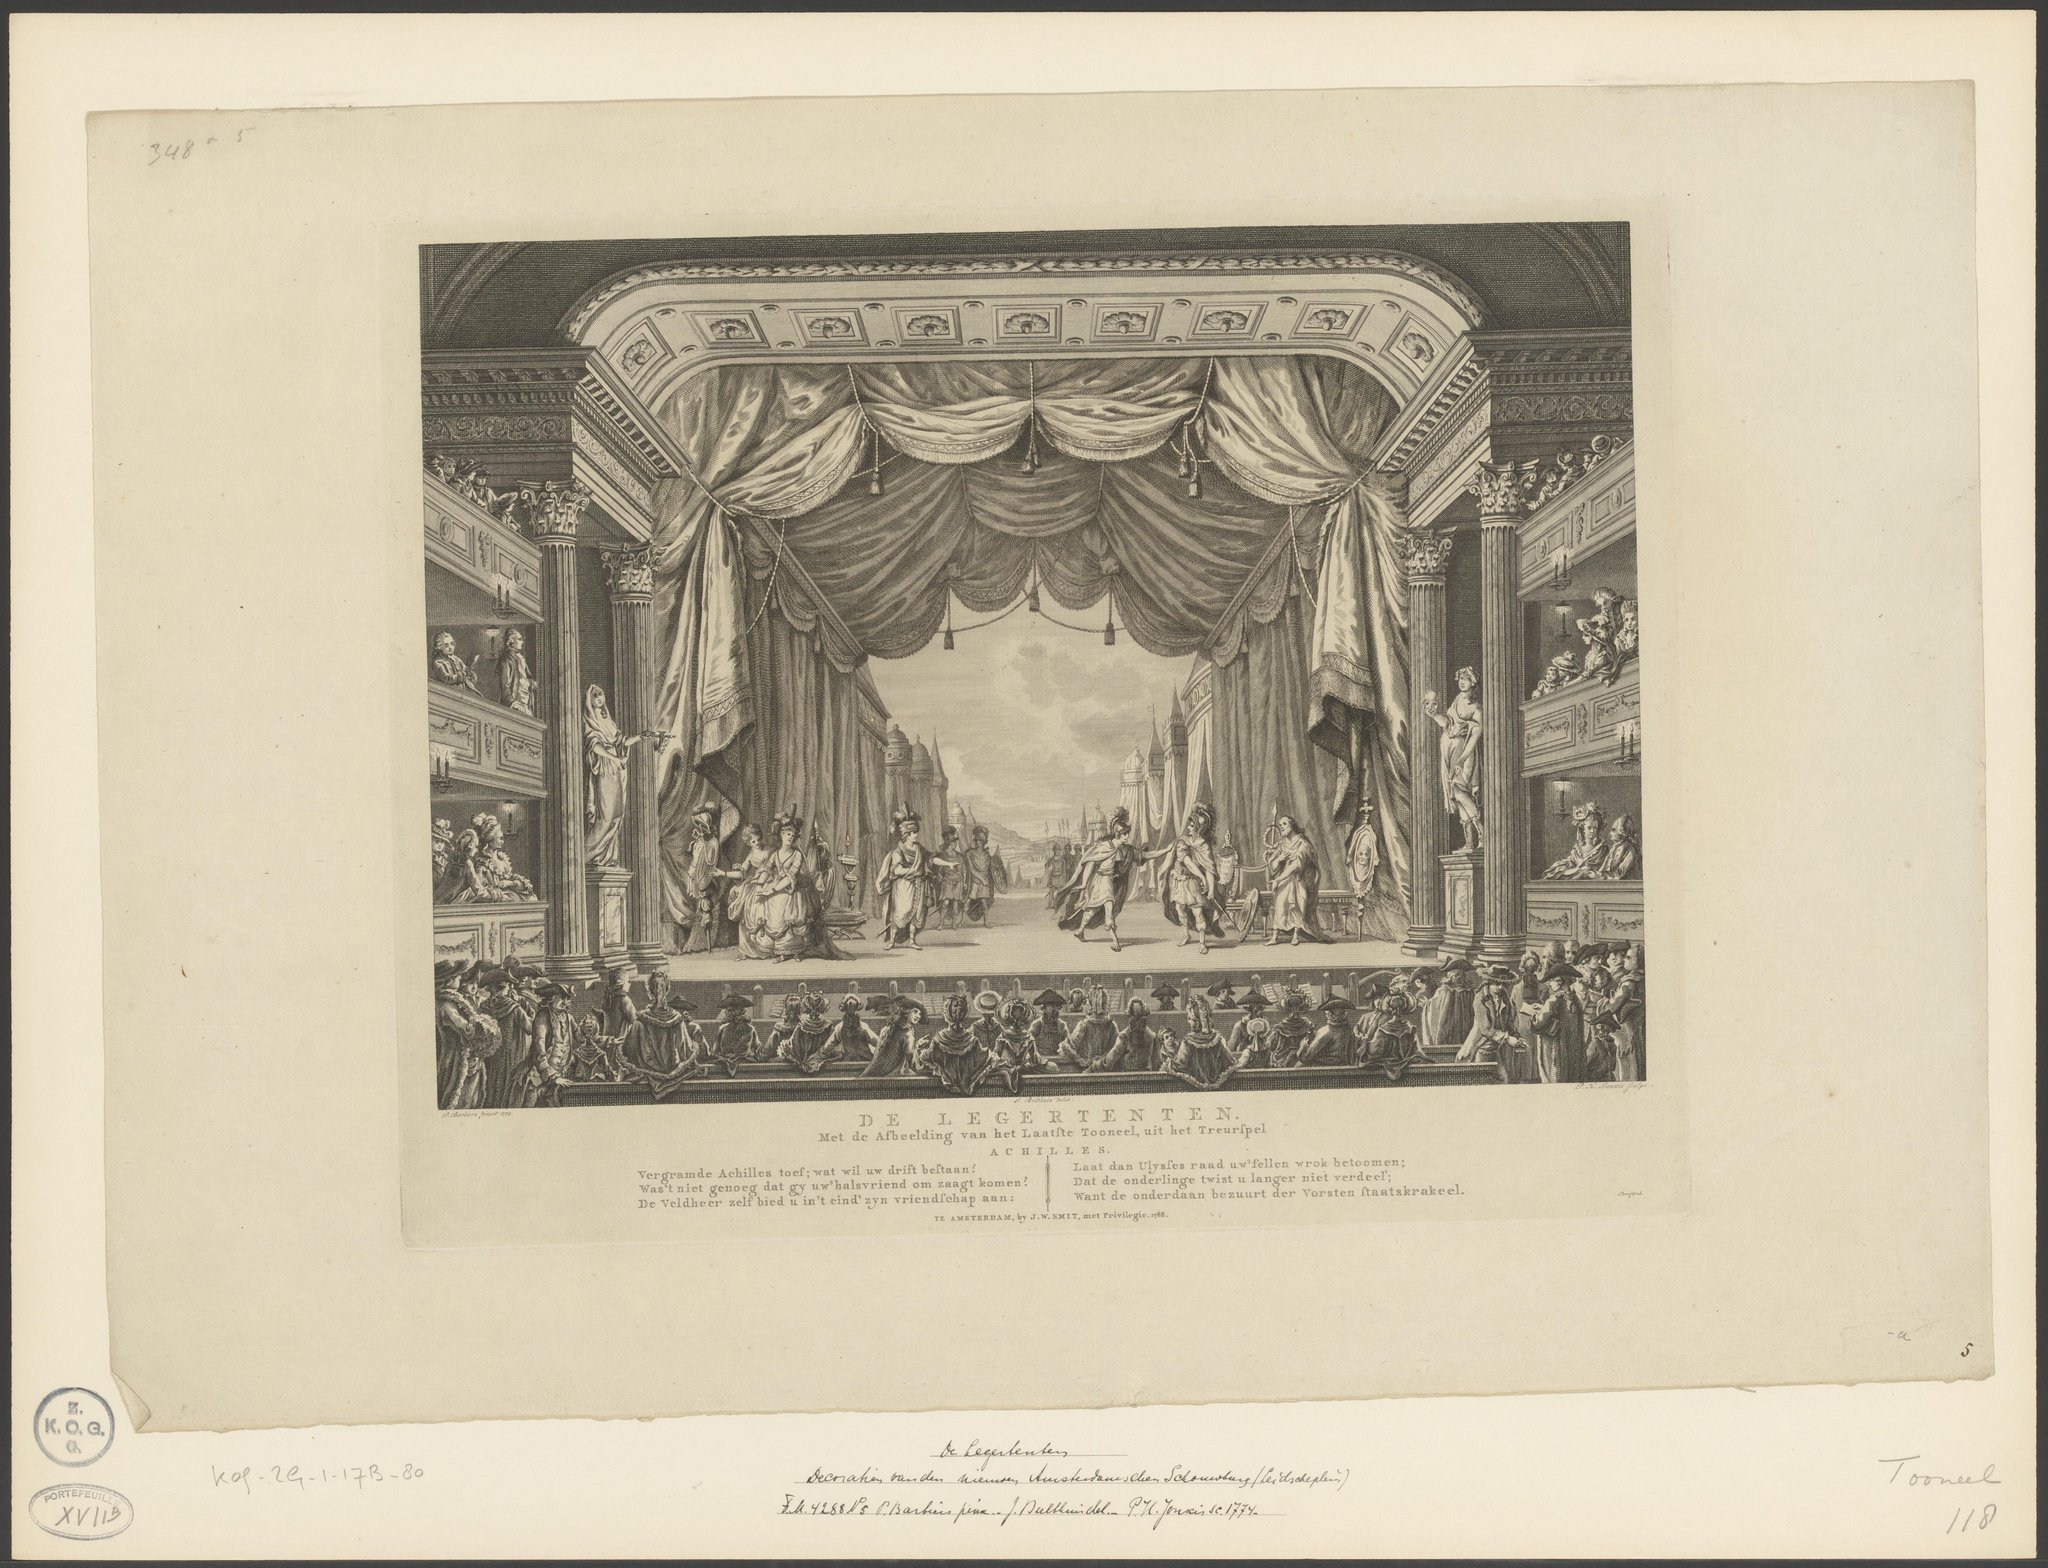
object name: print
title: De Legertenten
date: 1788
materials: paper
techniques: engraving, etching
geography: amsterdam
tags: theatre, theatrical performance, stage design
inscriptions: stamp, collector's mark: Lugt 1641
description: Toneelvoorstelling in de nieuwe Amsterdamse Schouwburg met het coulissendecor De Legertenten, met scène uit Achilles. Het decor gedrukt van een aparte plaat binnen een passe-partout met de zaal, zijloges, pilaren met standbeelden en de façade van het toneel. In het onderschrift een zesregelig vers. Onderdeel van de serie van veertien toneeldecors van de nieuwe Amsterdamse Schouwburg, 1787-1794. Onderwerpsrubrieken binnen de Atlas Zeden en Gewoonten: Schoone kunsten, Tooneel, Decors voor de Schouwburg.